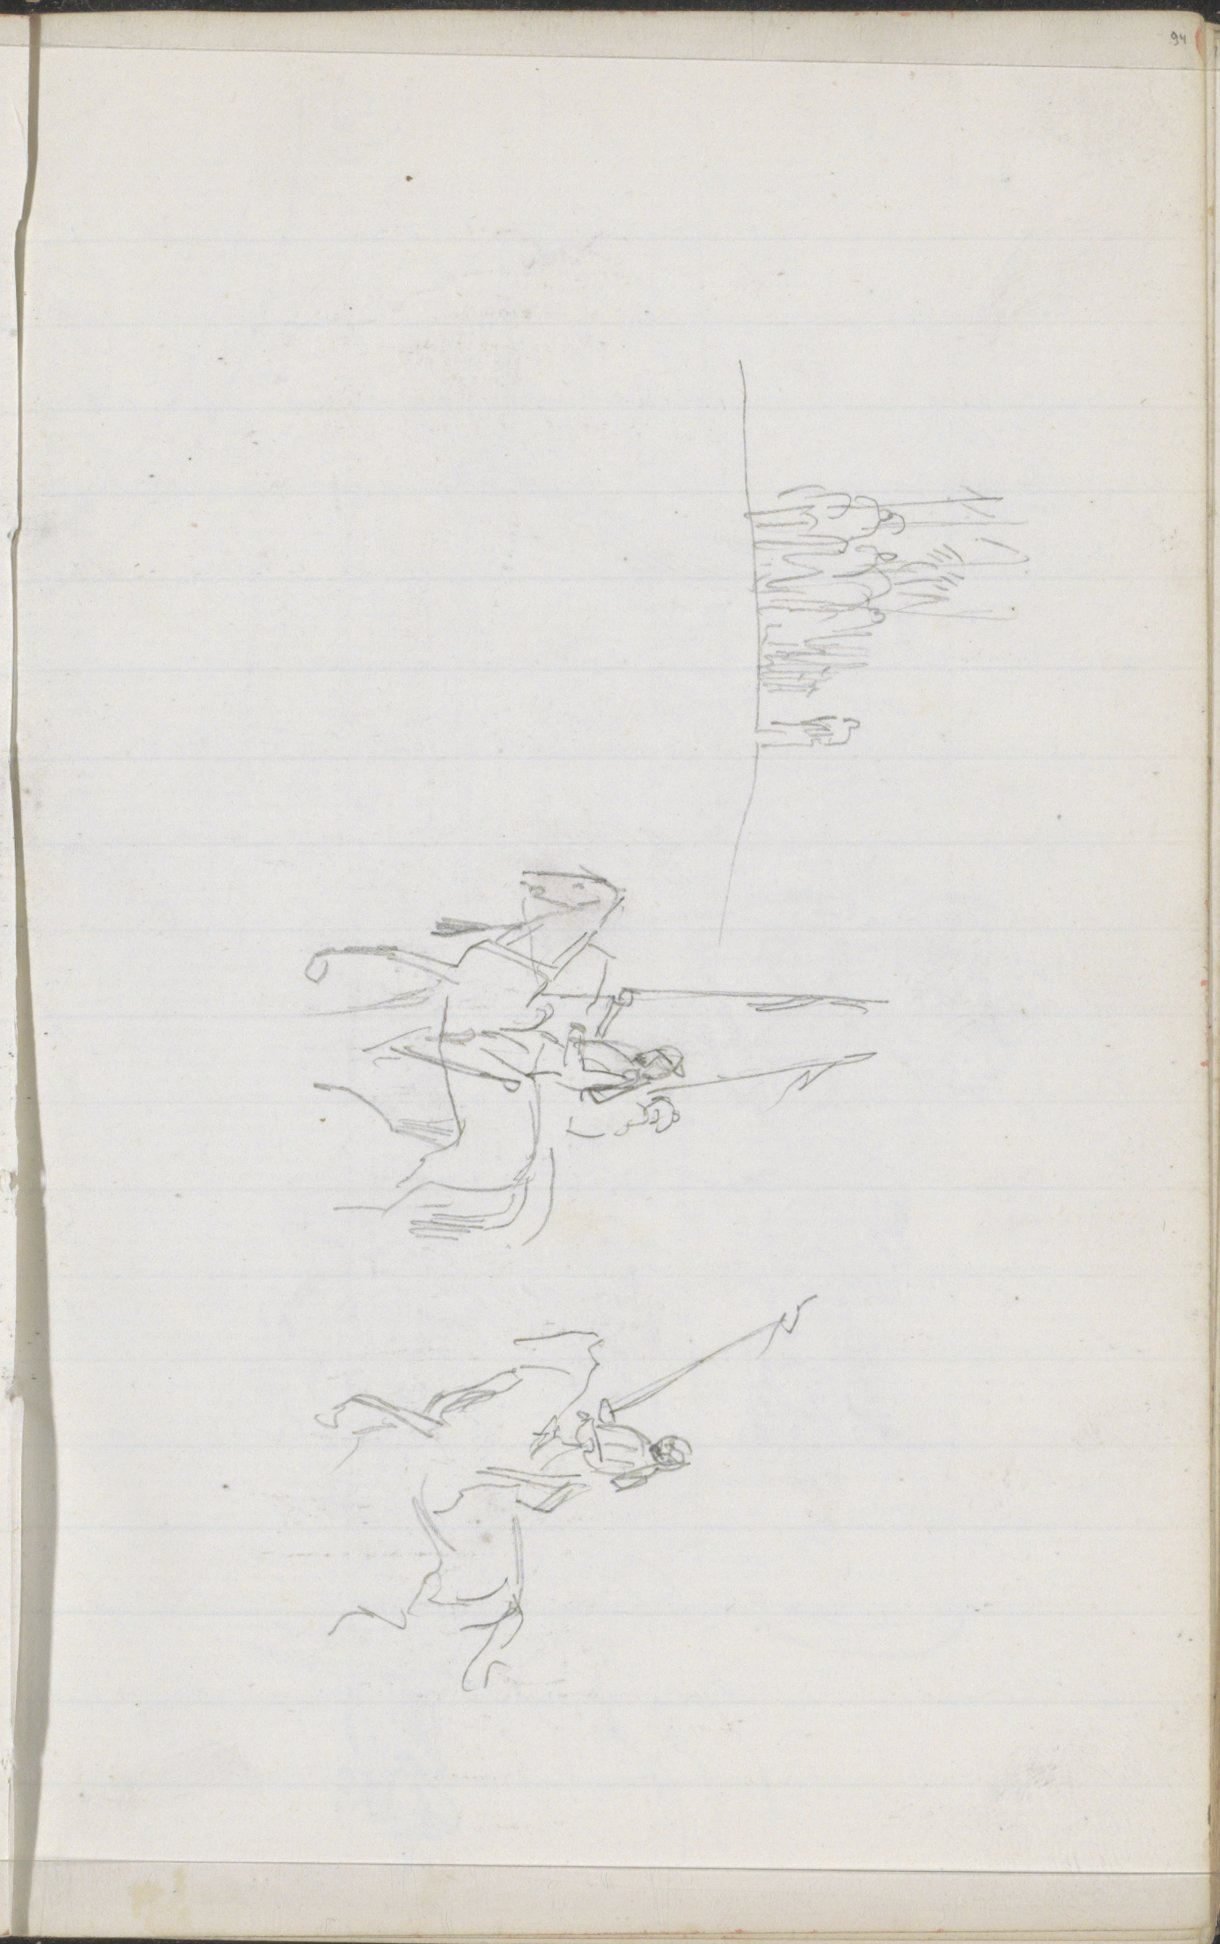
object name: sketchbook leaf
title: Indiase soldaten te paard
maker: marius bauer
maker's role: draughtsman, print maker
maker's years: 1867-1932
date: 1897-1898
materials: pencil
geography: india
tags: riding a horse, ass, or mule; rider, horseman, flags (~ signalling)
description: De soldaten dragen vlaggen. Pagina 94 uit een schetsboek met 62 bladen.